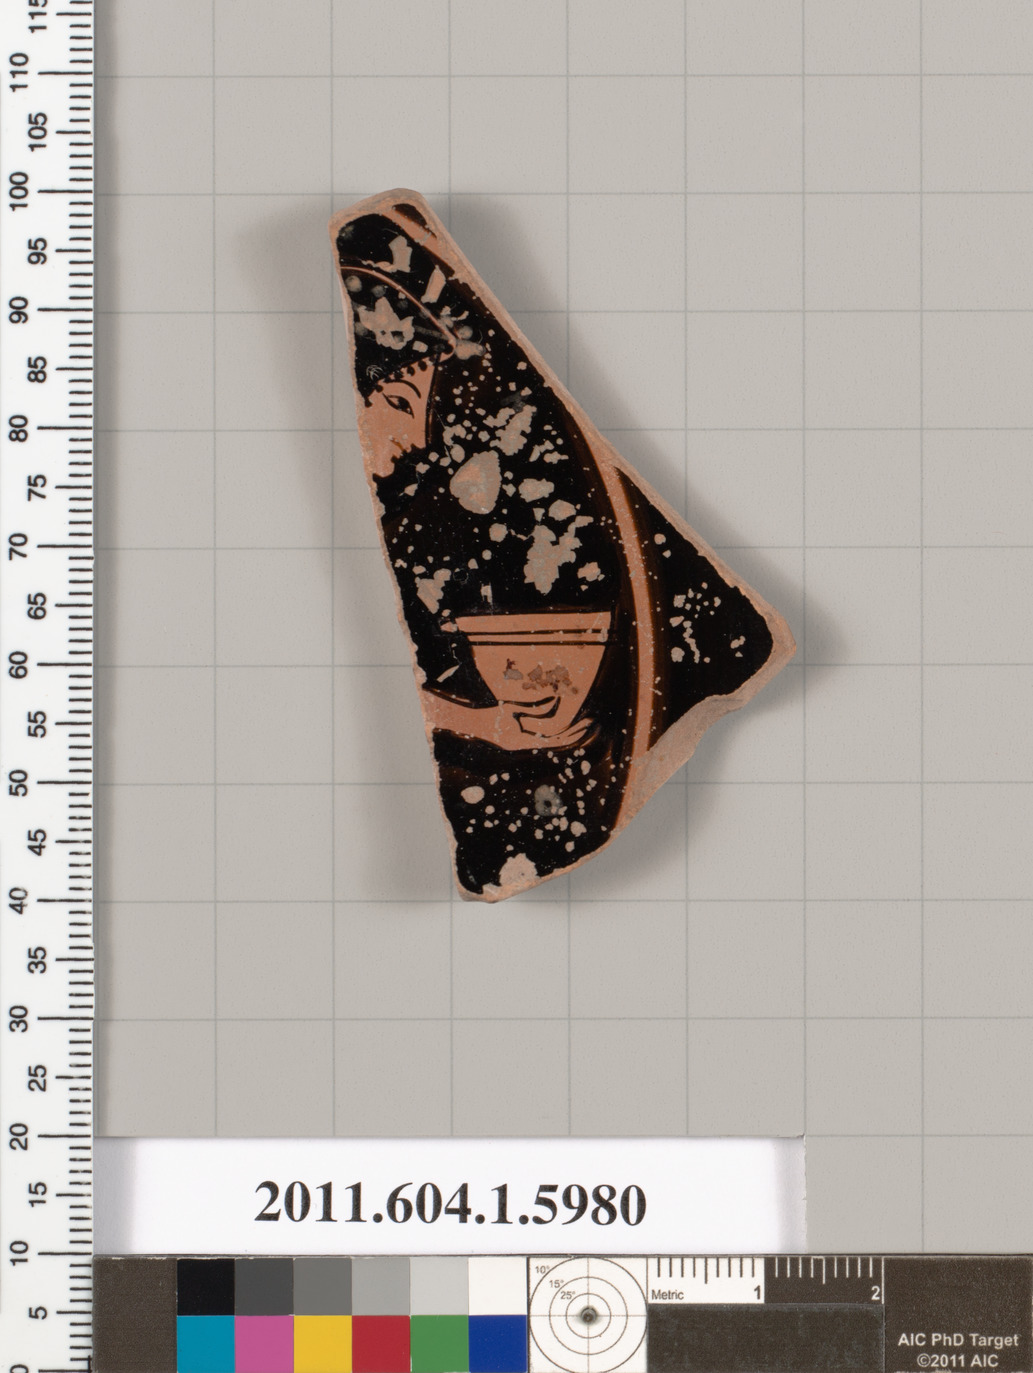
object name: kylix fragment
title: Terracotta fragment of a kylix (drinking cup)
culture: greek, attic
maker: euergides painter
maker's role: artist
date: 510-500 BCE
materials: terracotta